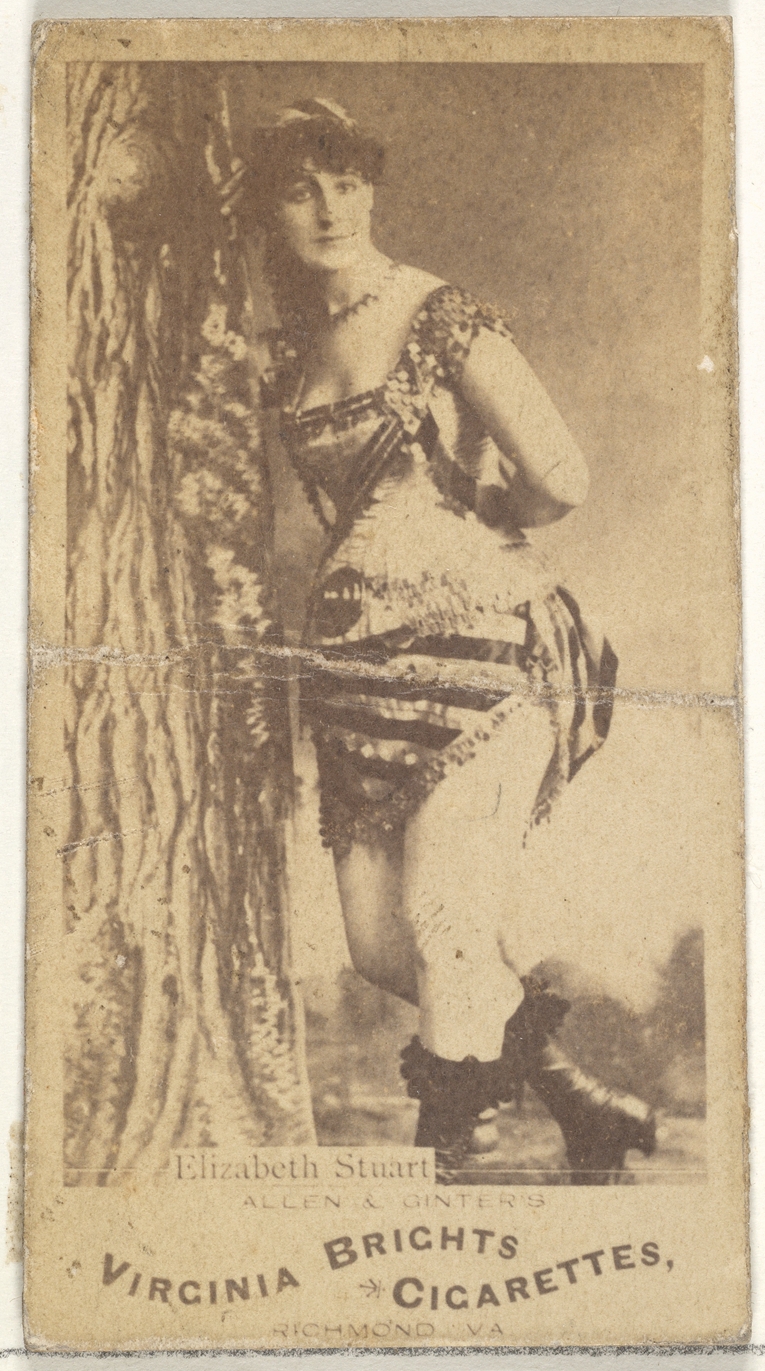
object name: photograph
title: Elizabeth Stuart, from the Actors and Actresses series (N45, Type 1) for Virginia Brights Cigarettes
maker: allen & ginter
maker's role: publisher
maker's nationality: american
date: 1888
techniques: albumen silver print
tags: portraits,women,actresses